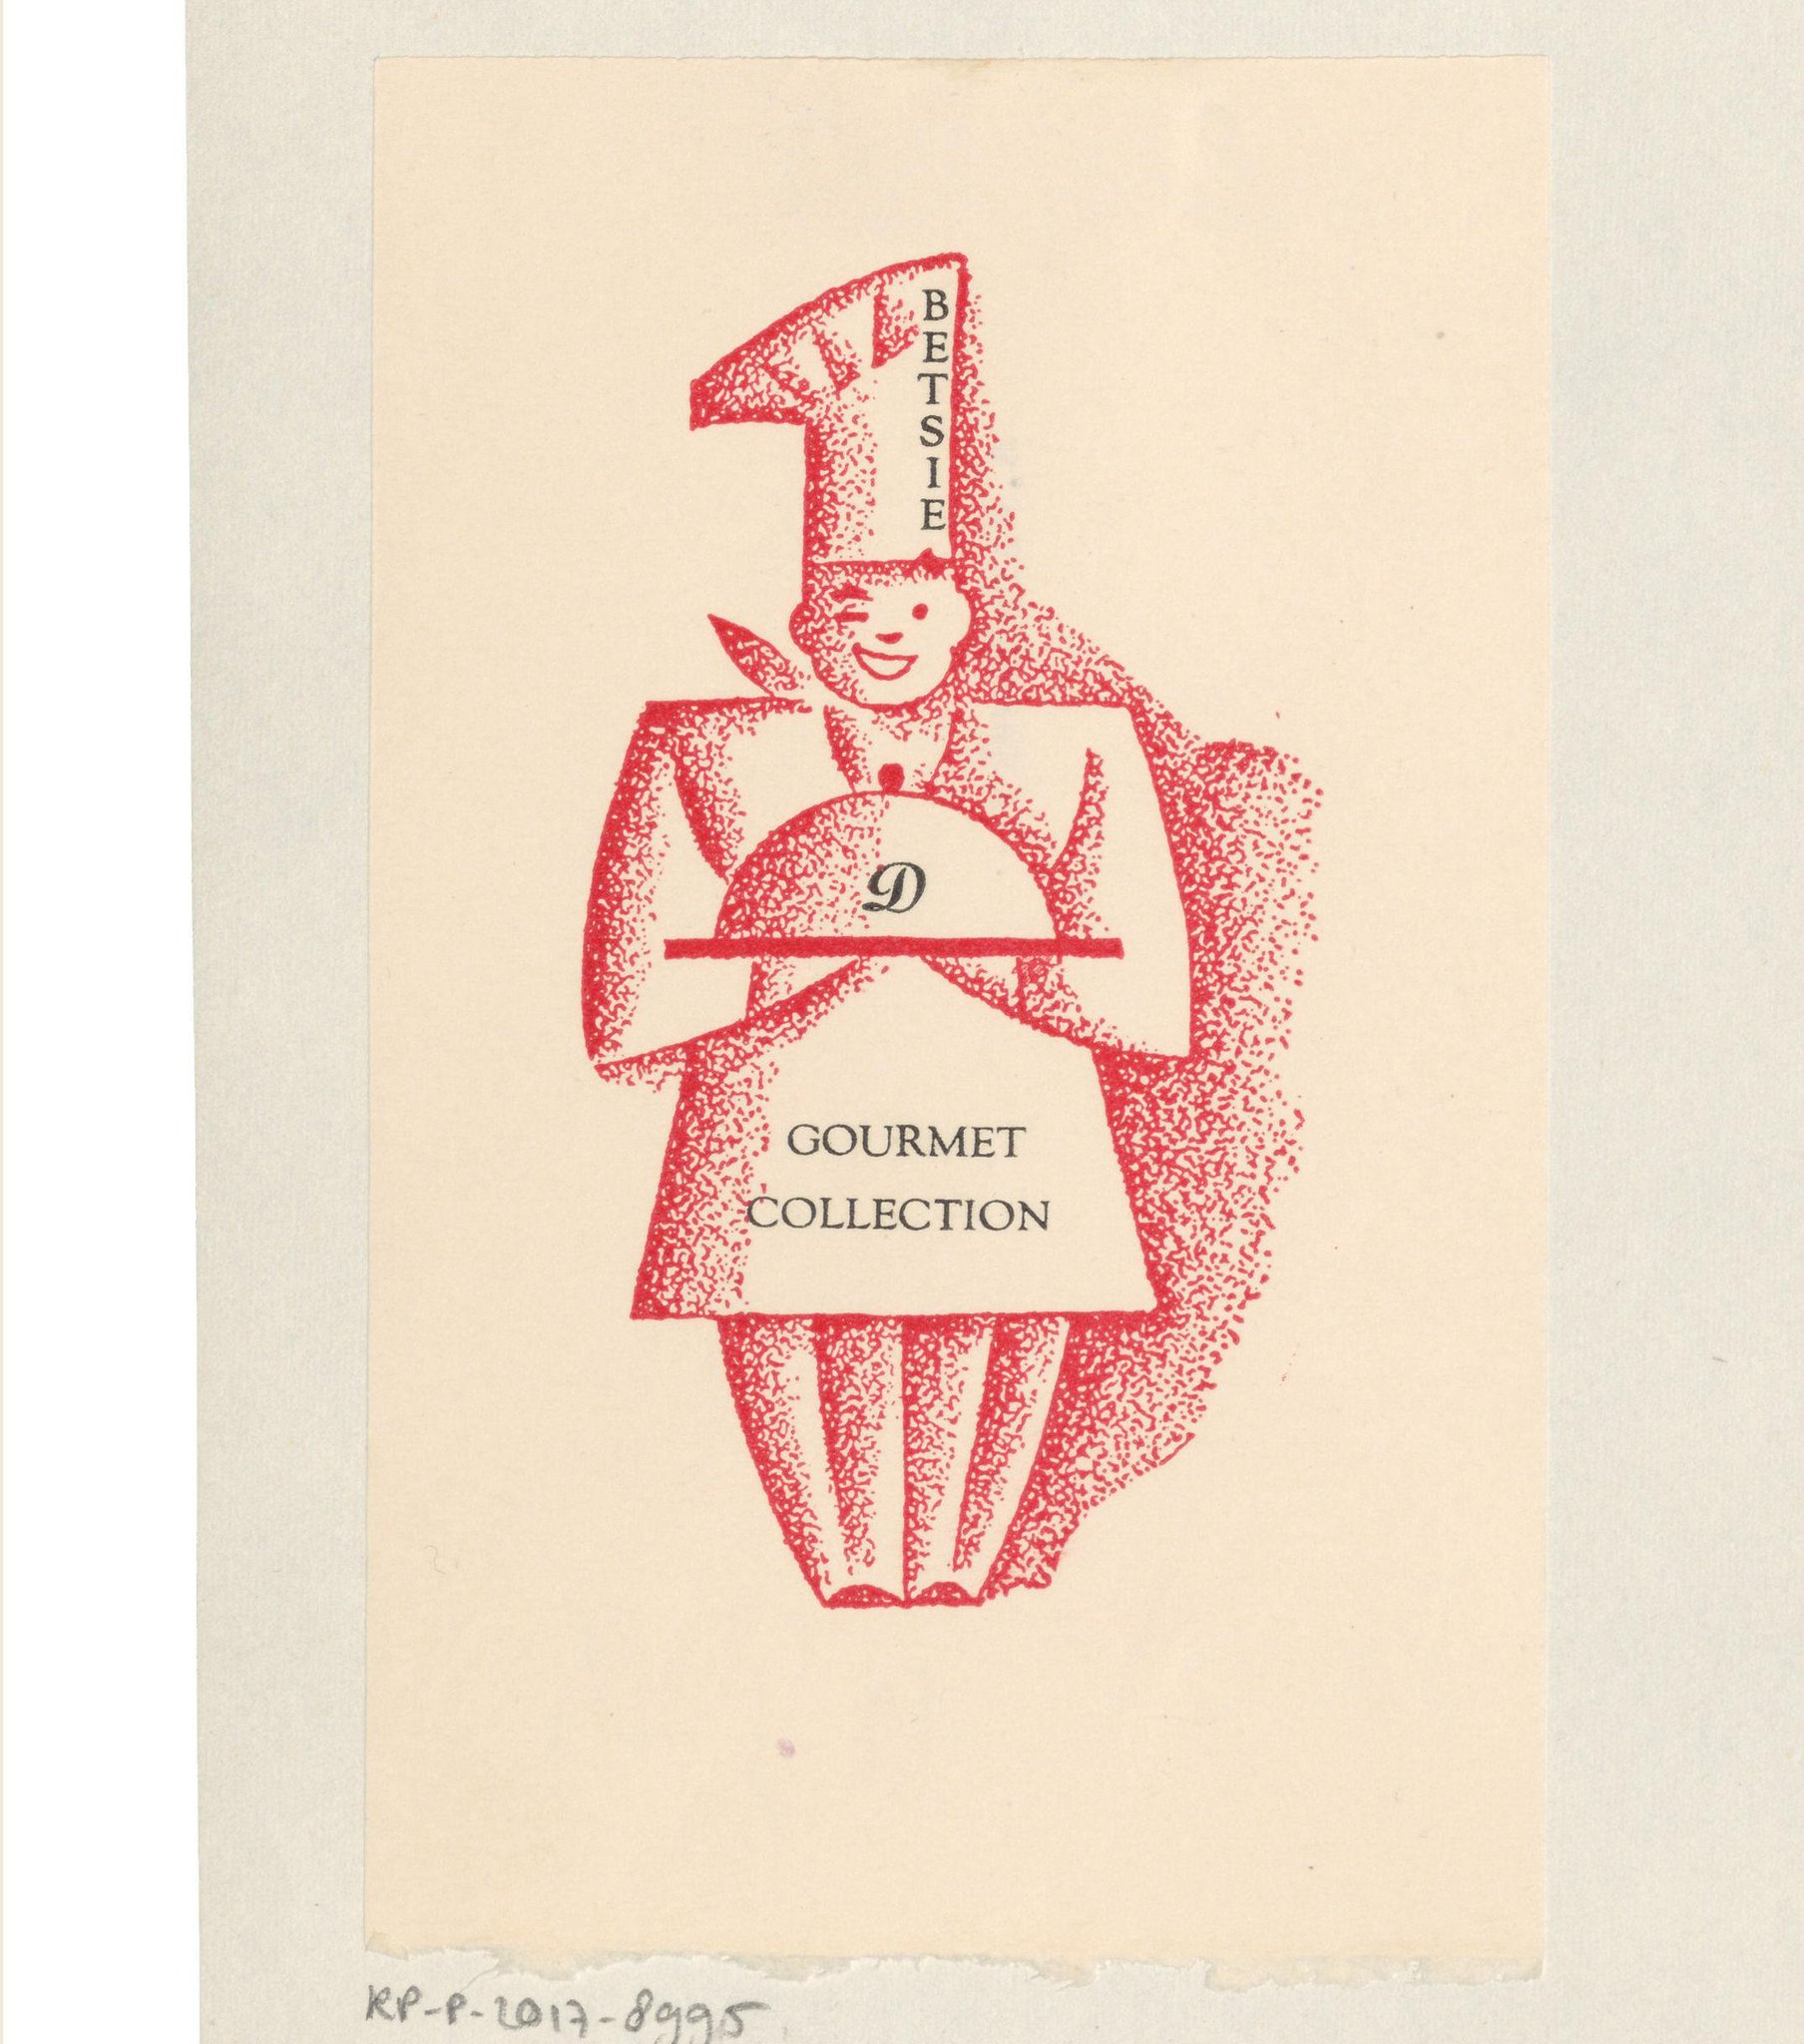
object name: bookplate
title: Ex libris van Betsie D.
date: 1900-1945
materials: paper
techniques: printing block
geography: north and central america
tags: cook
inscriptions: workshop stamp: ‘A. Warshawsky’